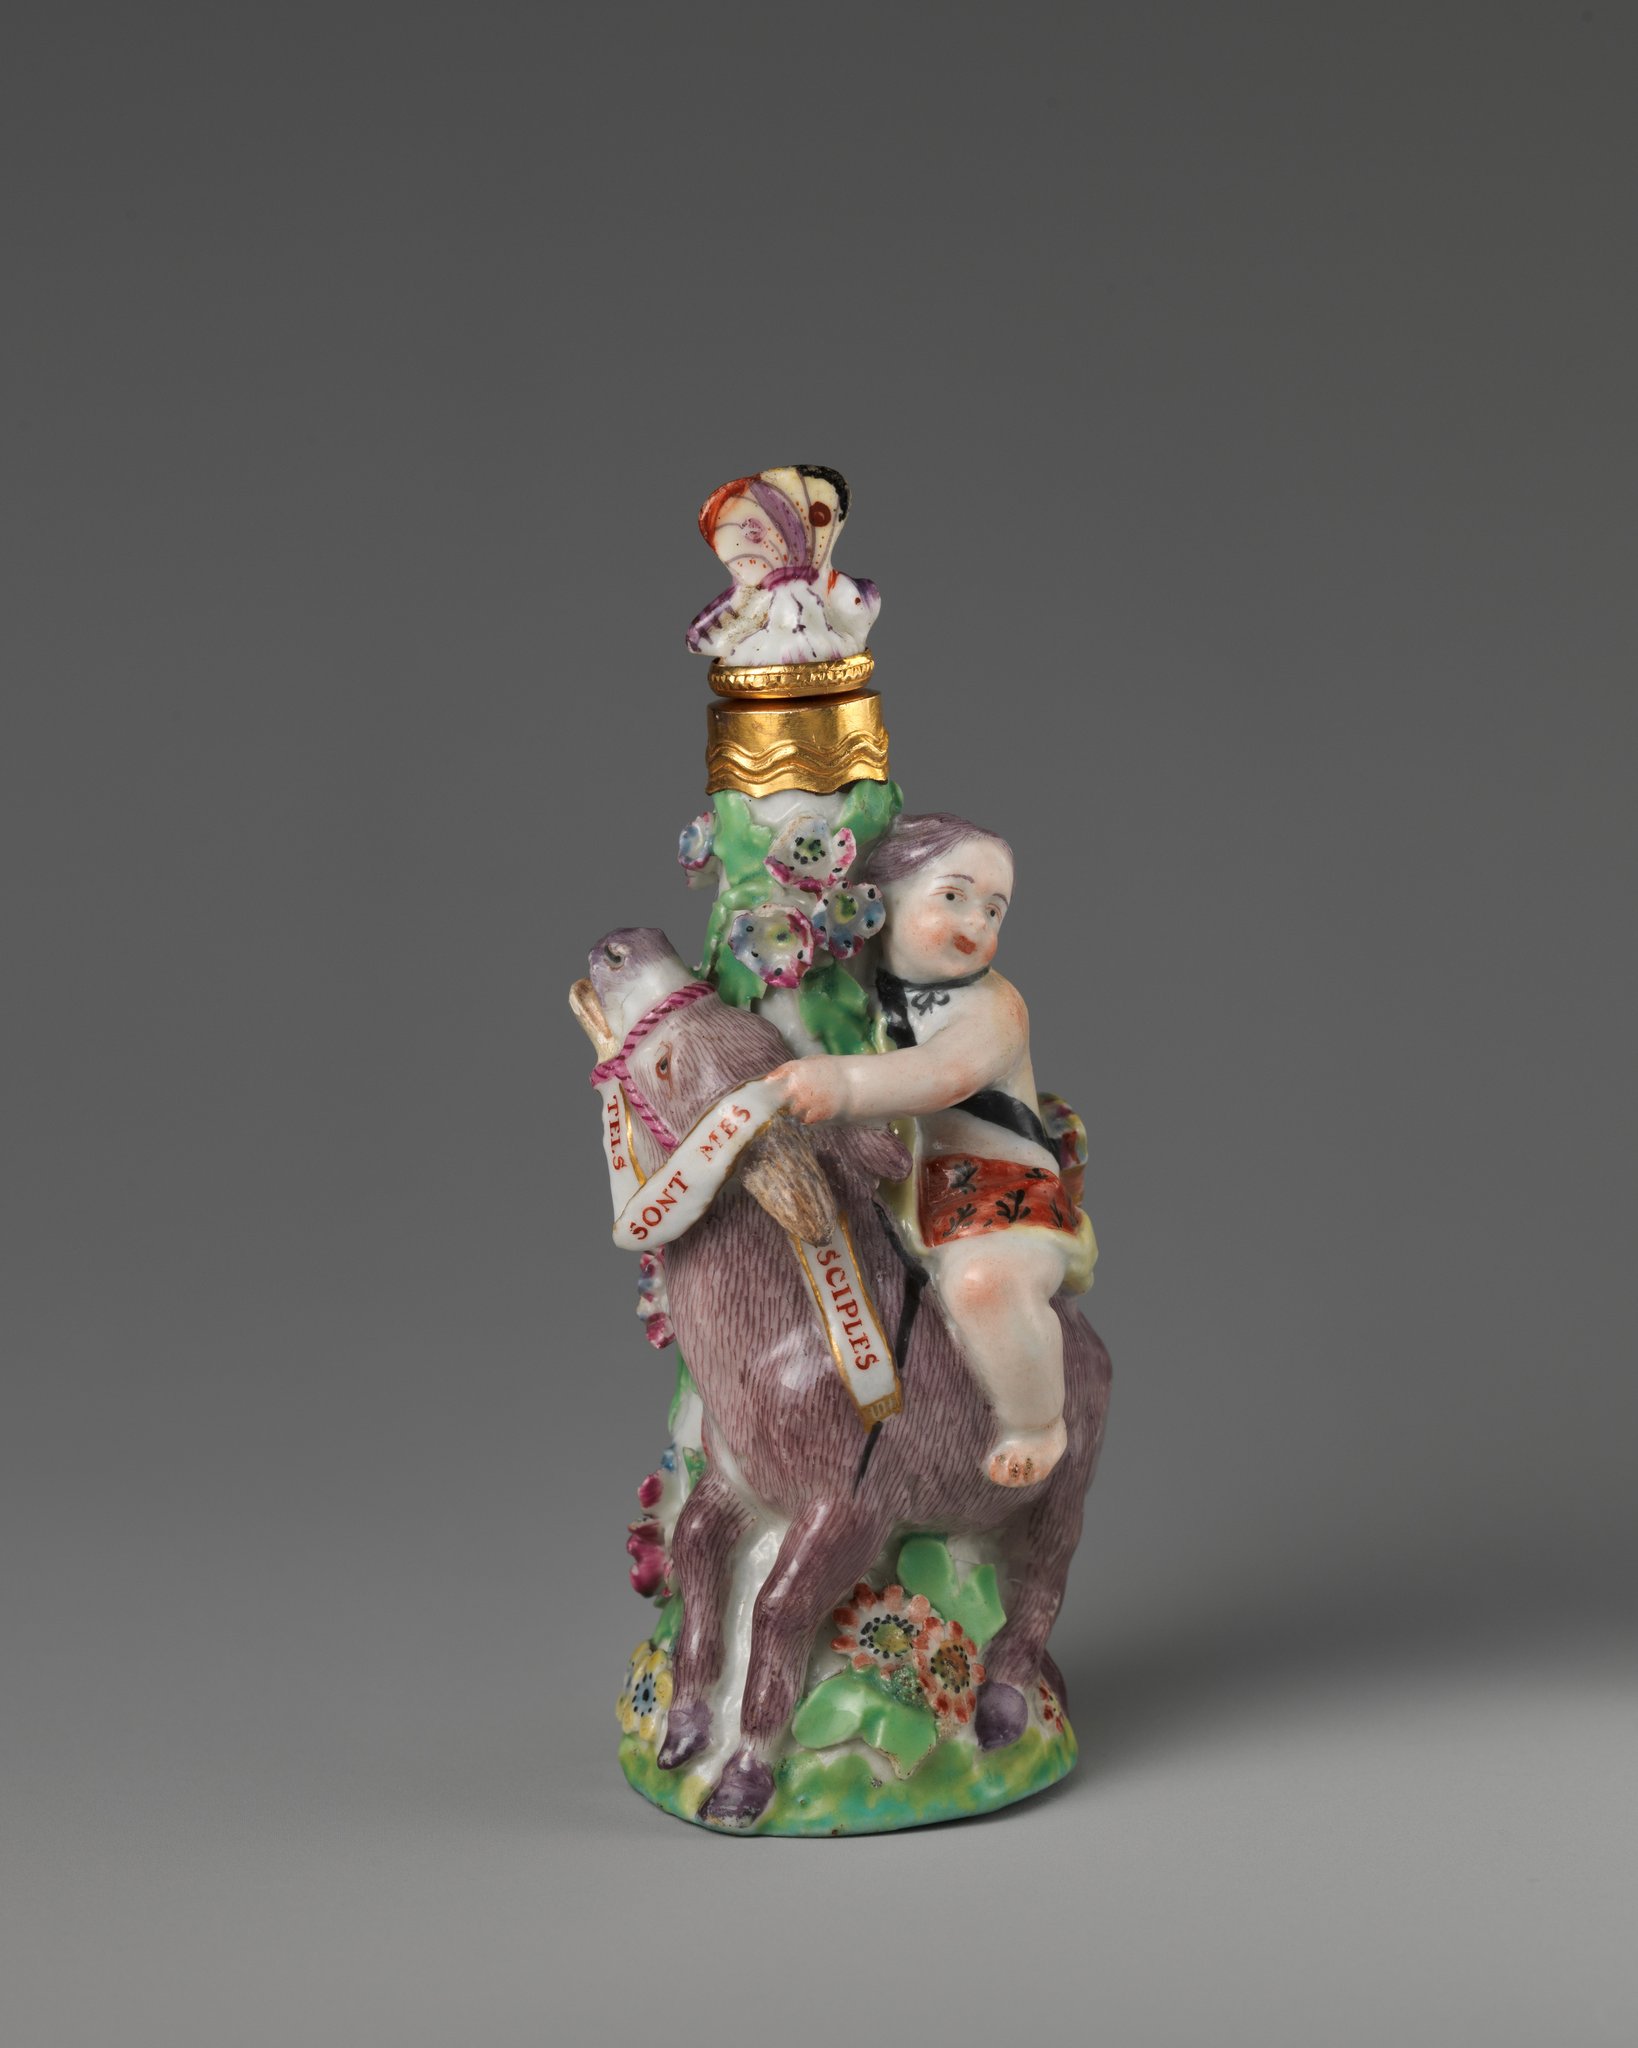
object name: toy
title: Cupid on a donkey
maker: chelsea porcelain manufactory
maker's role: factory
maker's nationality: british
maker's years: 1744-1784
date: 1765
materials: soft paste porcelain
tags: cupid,donkeys,flowers